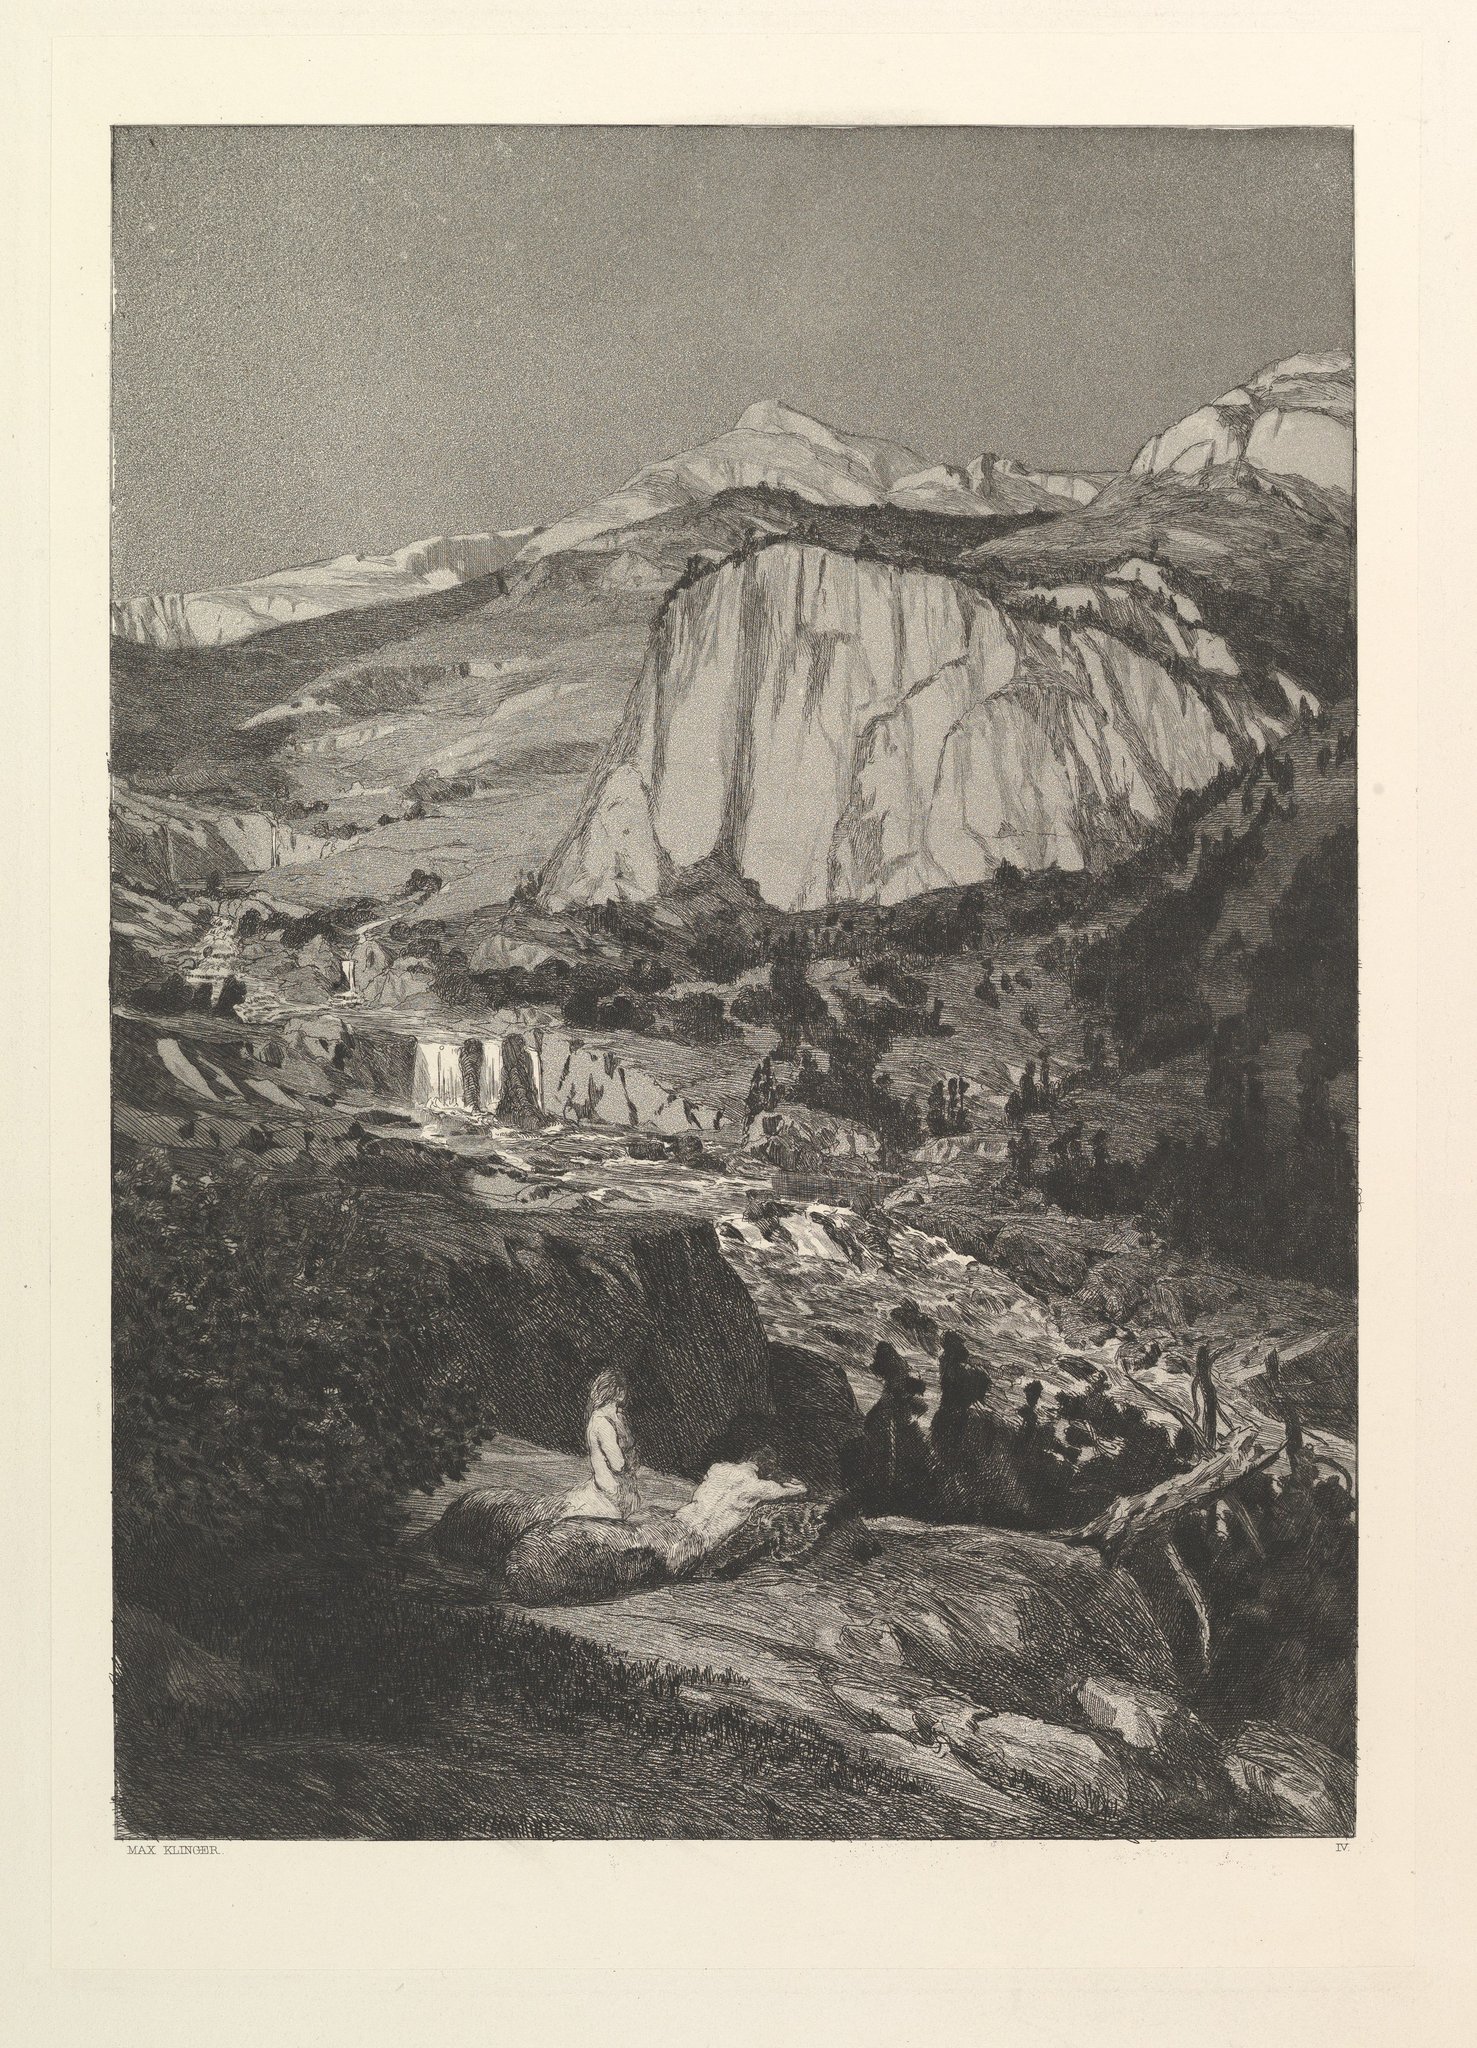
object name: print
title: Mondnacht, from Intermezzi, plate 4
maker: max klinger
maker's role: artist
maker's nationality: german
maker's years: 1857-1920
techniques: aquatint, etching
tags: human figures,mountains,landscapes